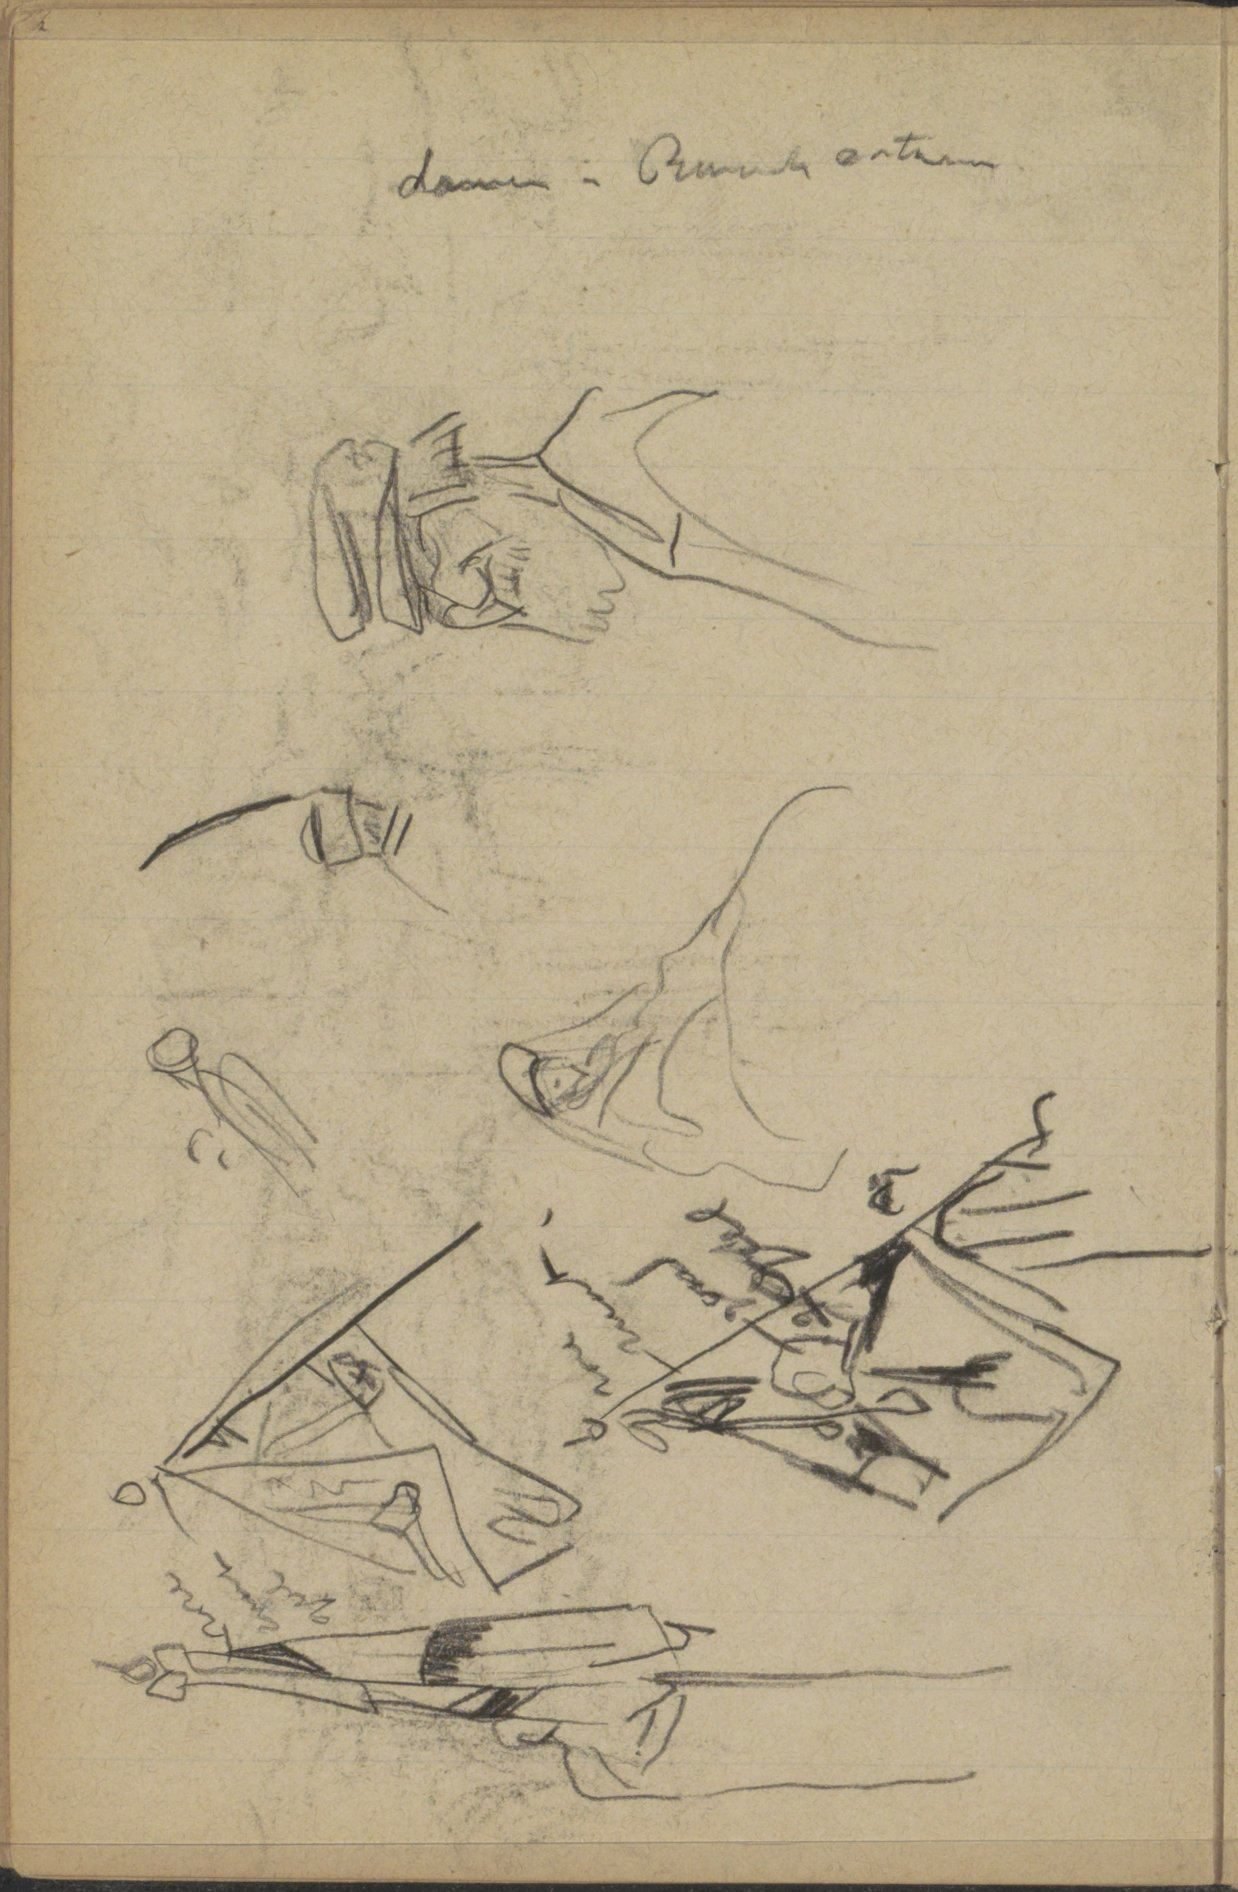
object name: sketchbook leaf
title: Figuurstudies en vaandels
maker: marius bauer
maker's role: draughtsman, print maker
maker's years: 1867-1932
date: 1896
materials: chalk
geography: moscow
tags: head (human), (military) flags and standards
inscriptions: annotation: ‘[...]’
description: De vaandels maakten mogelijk deel uit van de stoet voor de kroning van tsaar Nicolaas II. Pagina 62 uit een schetsboek met 50 bladen.